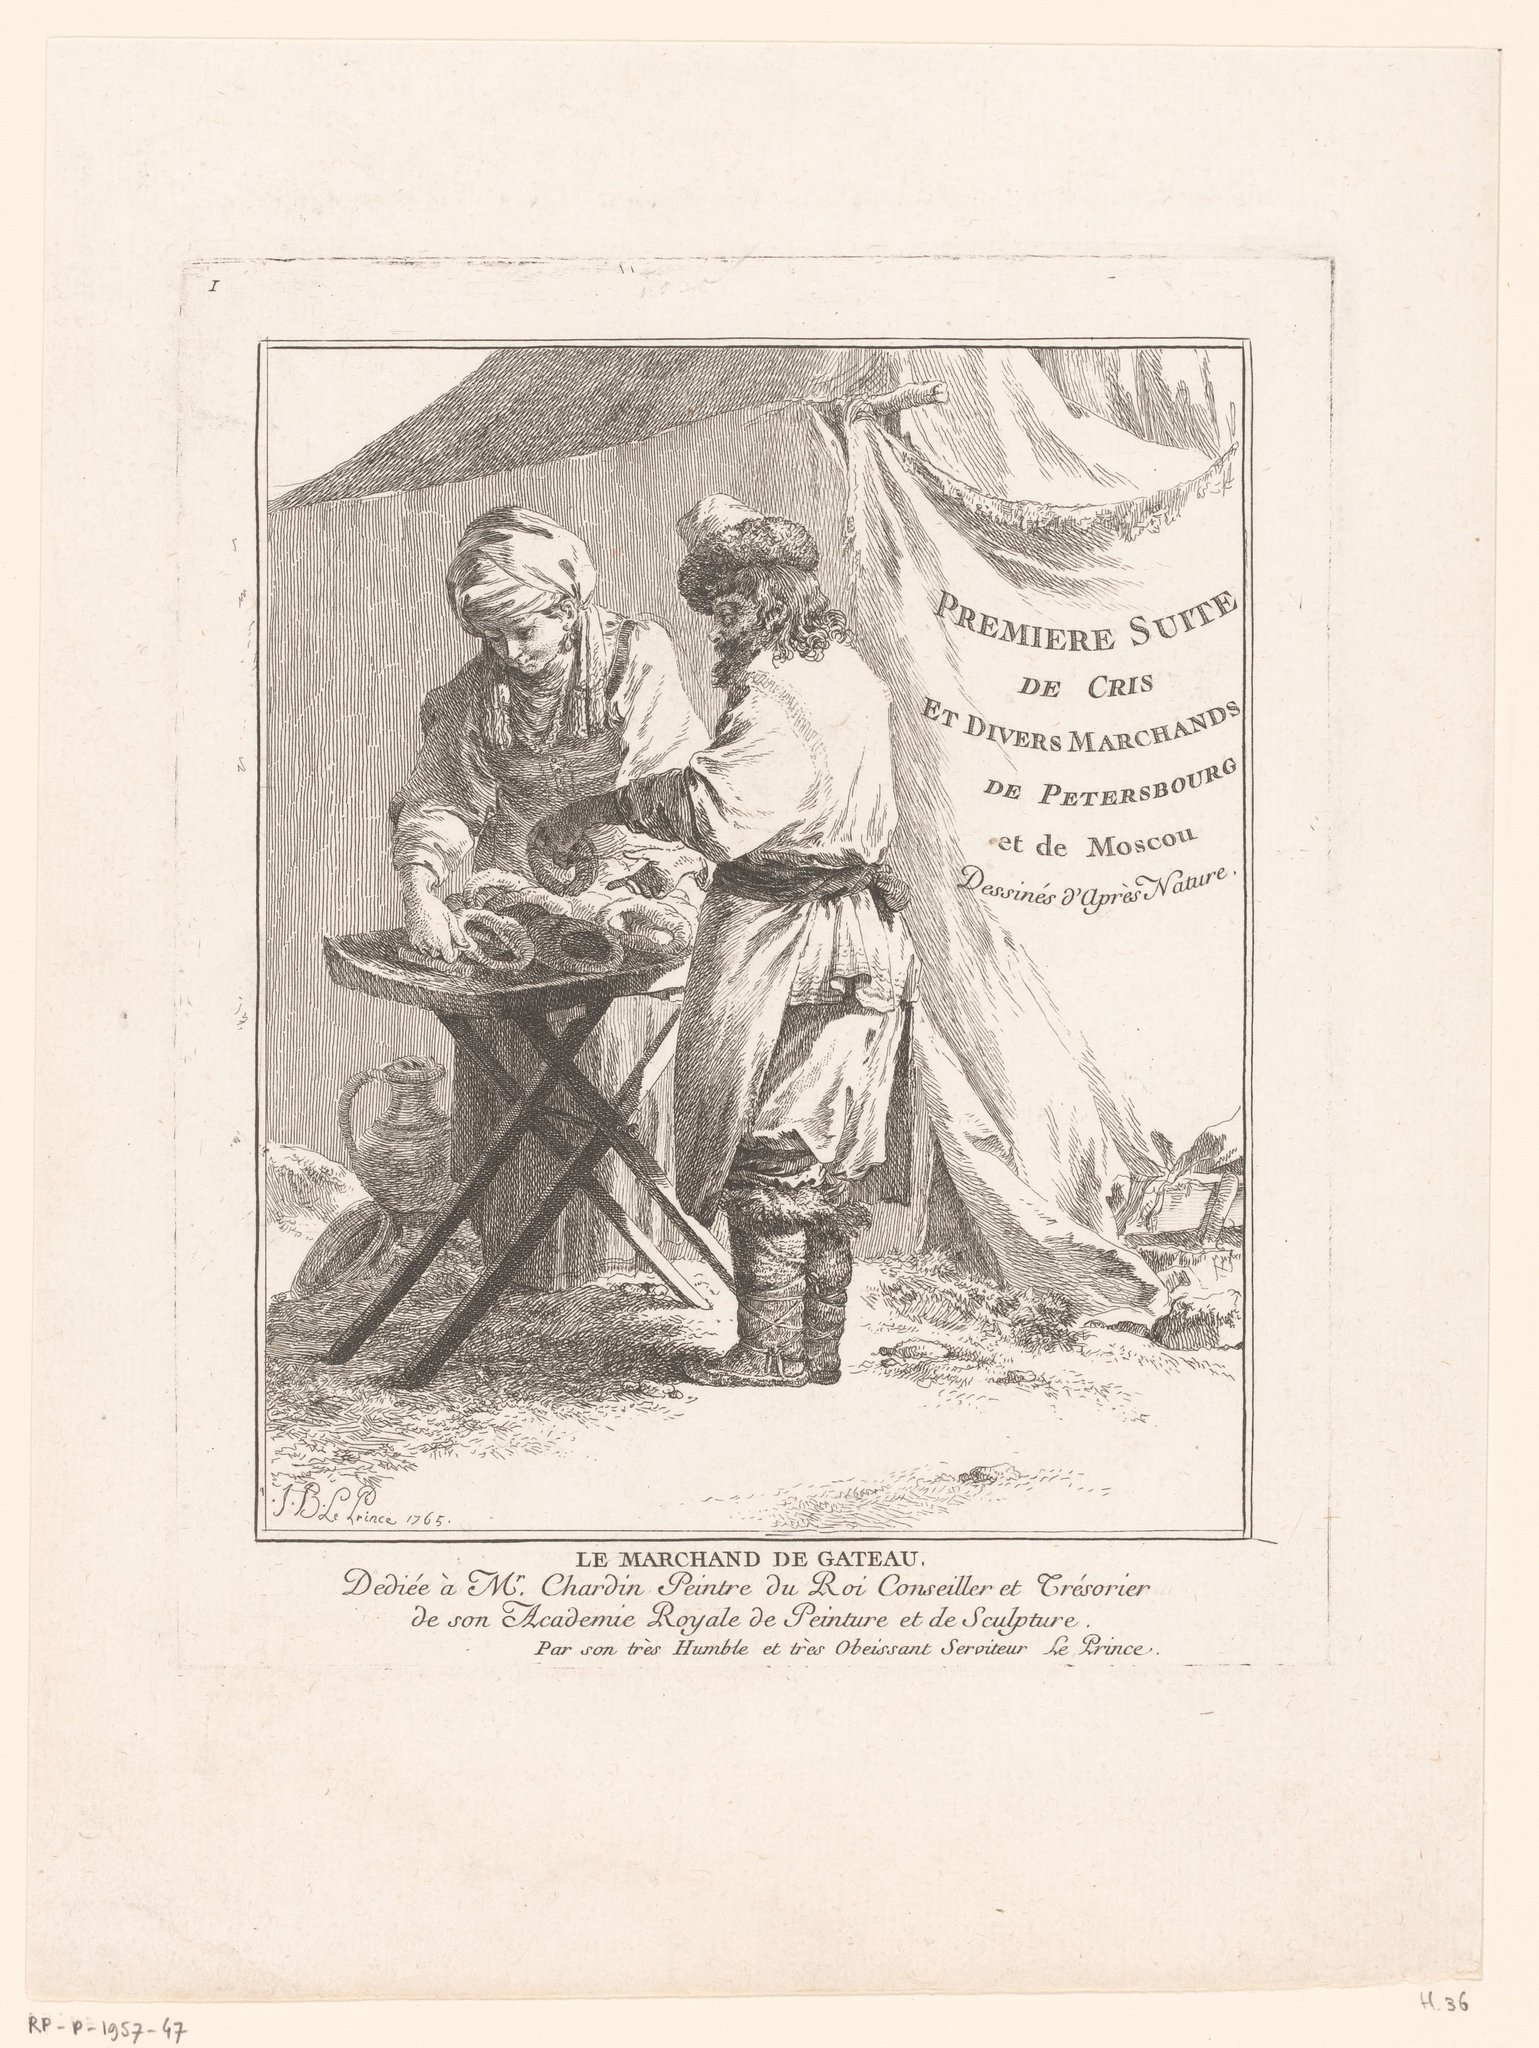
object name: print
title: Handelaren en straatverkopers uit Sint-Petersburg en Moskou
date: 1765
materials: paper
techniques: etching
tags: bread, cake, pastry, etc., head-gear: cap (+ fur used for clothes), merchant, salesman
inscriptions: collector's mark: ‘Douane Centrale. Exportation Paris’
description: Titelprent van een zesdelige serie met handelaren en straatverkopers uit Sint-Petersburg en Moskou.